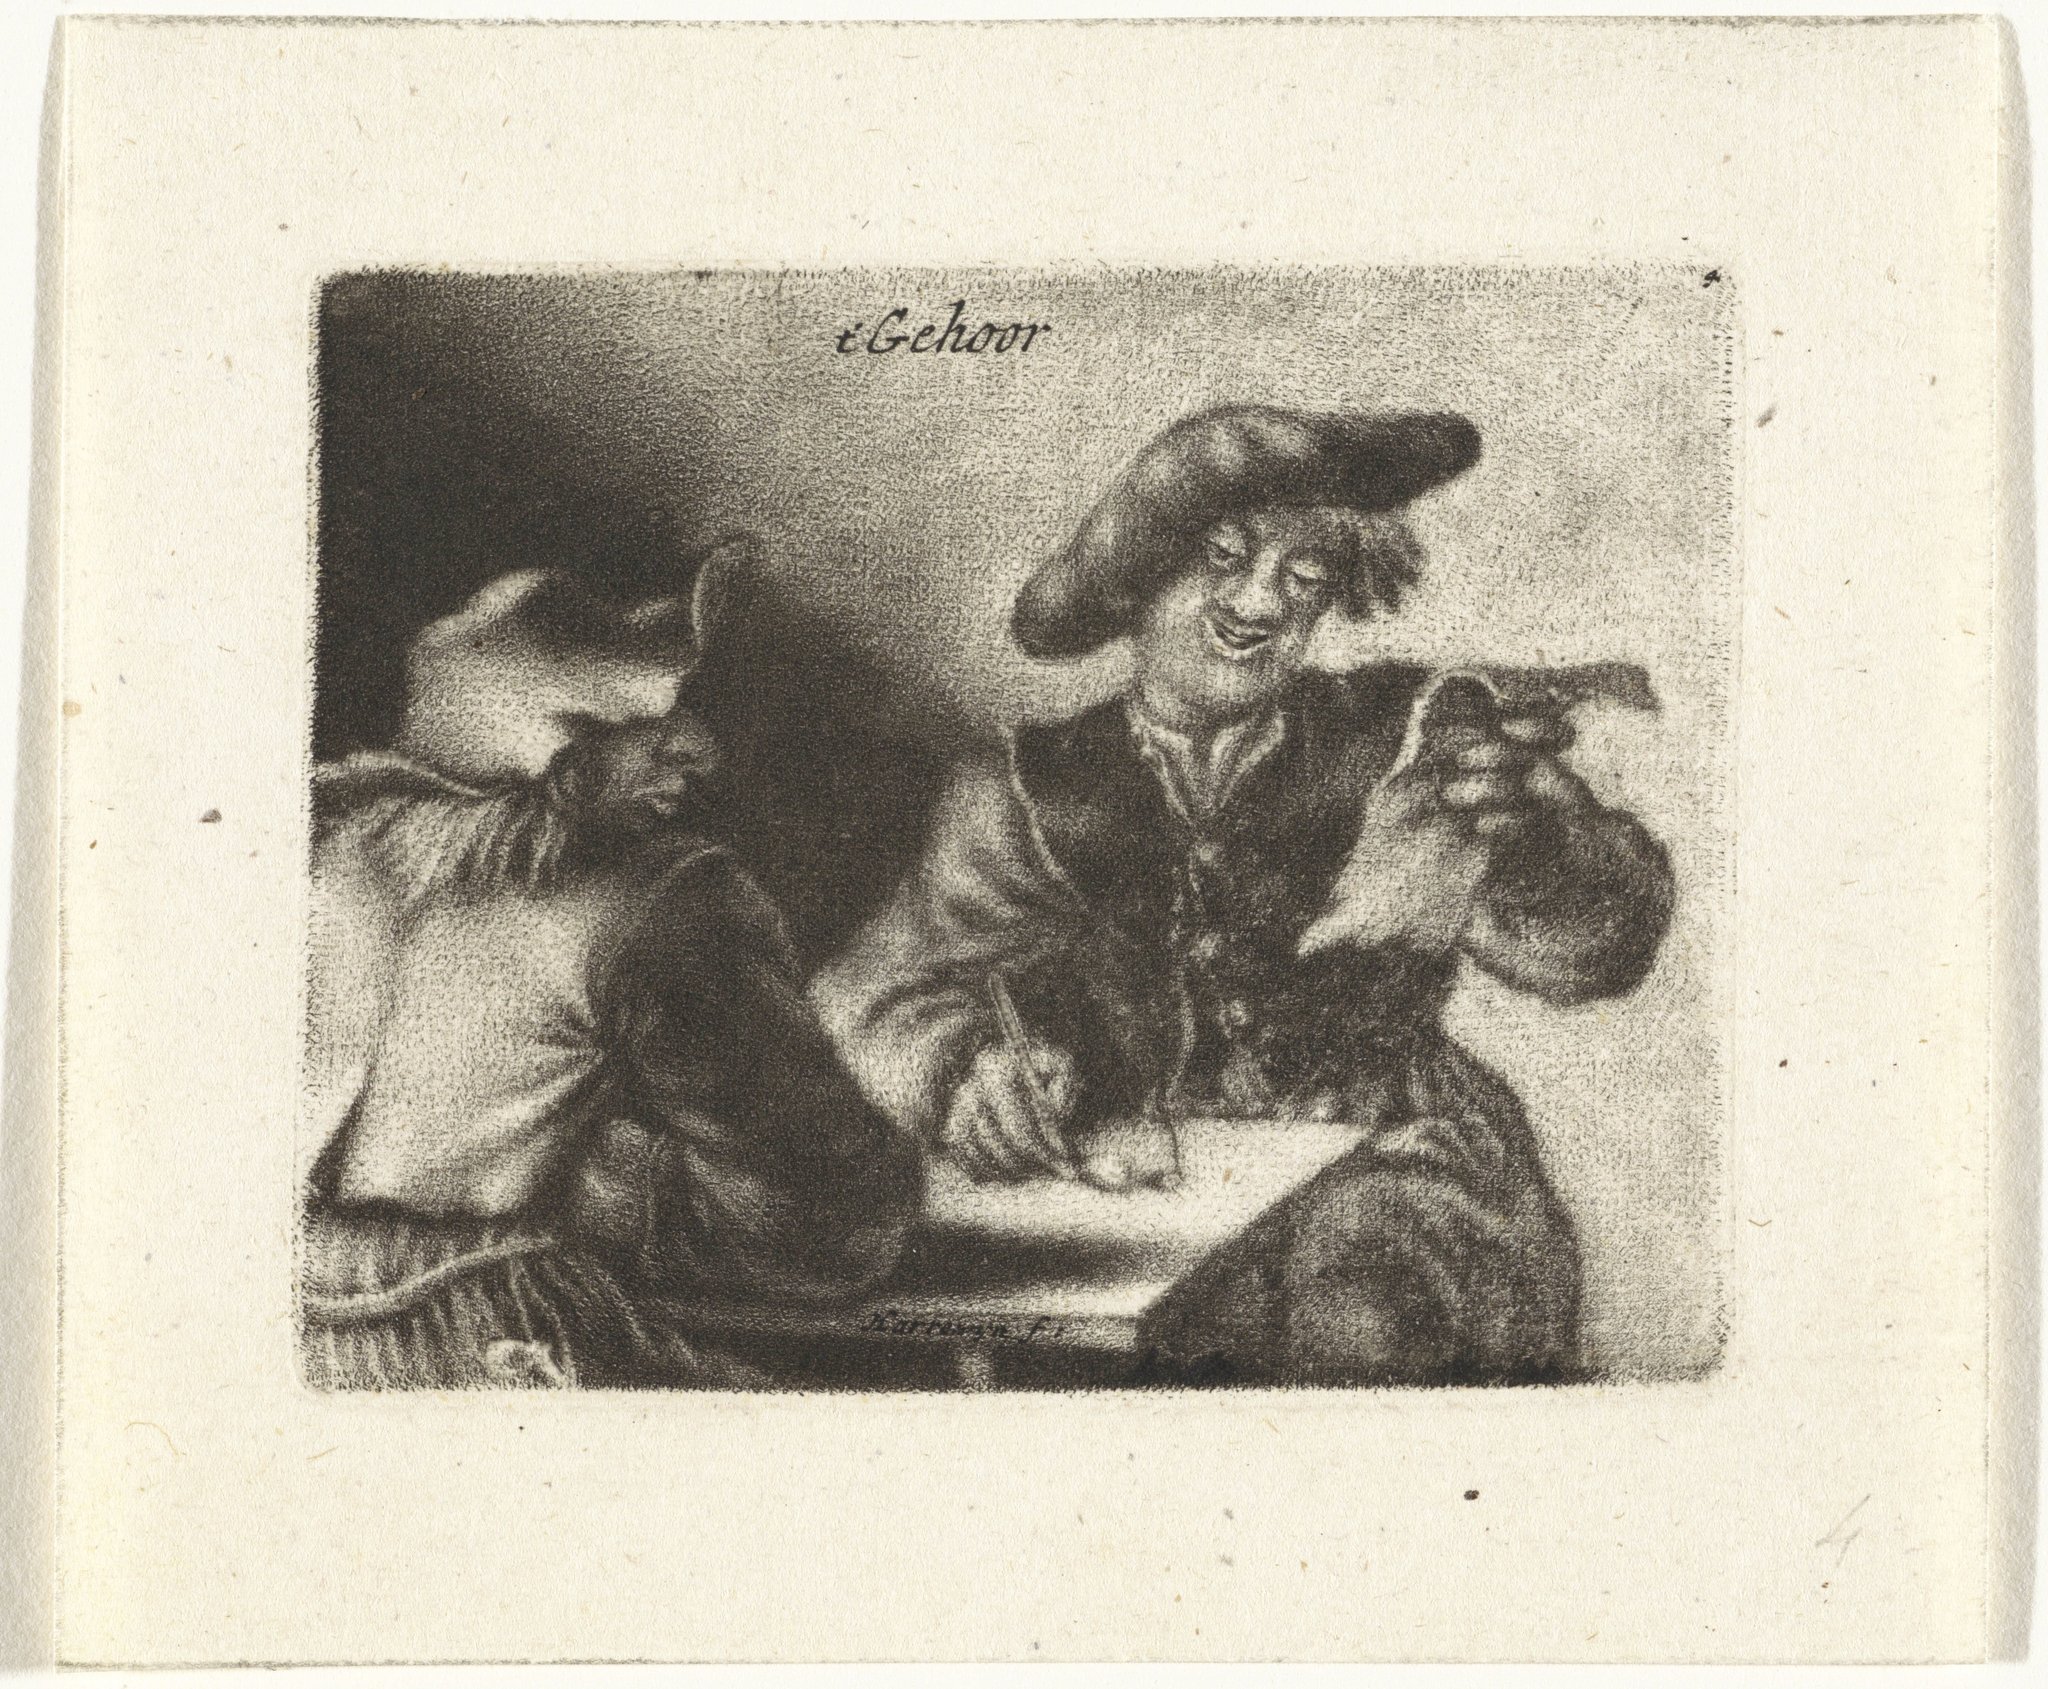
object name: print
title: Voorlezer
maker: jacobus harrewijn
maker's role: print maker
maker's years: 1660-1740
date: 1690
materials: paper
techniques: engraving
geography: southern netherlands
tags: hearing, listening (one of the five senses), pipe ~ tobacco, reading to somebody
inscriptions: collector's mark: Lugt 2228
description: Het Gehoor. Een pijprokende man leest een andere man een brief voor. De prent maakt deel uit van een serie van vijf prenten met de vijf zintuigen.